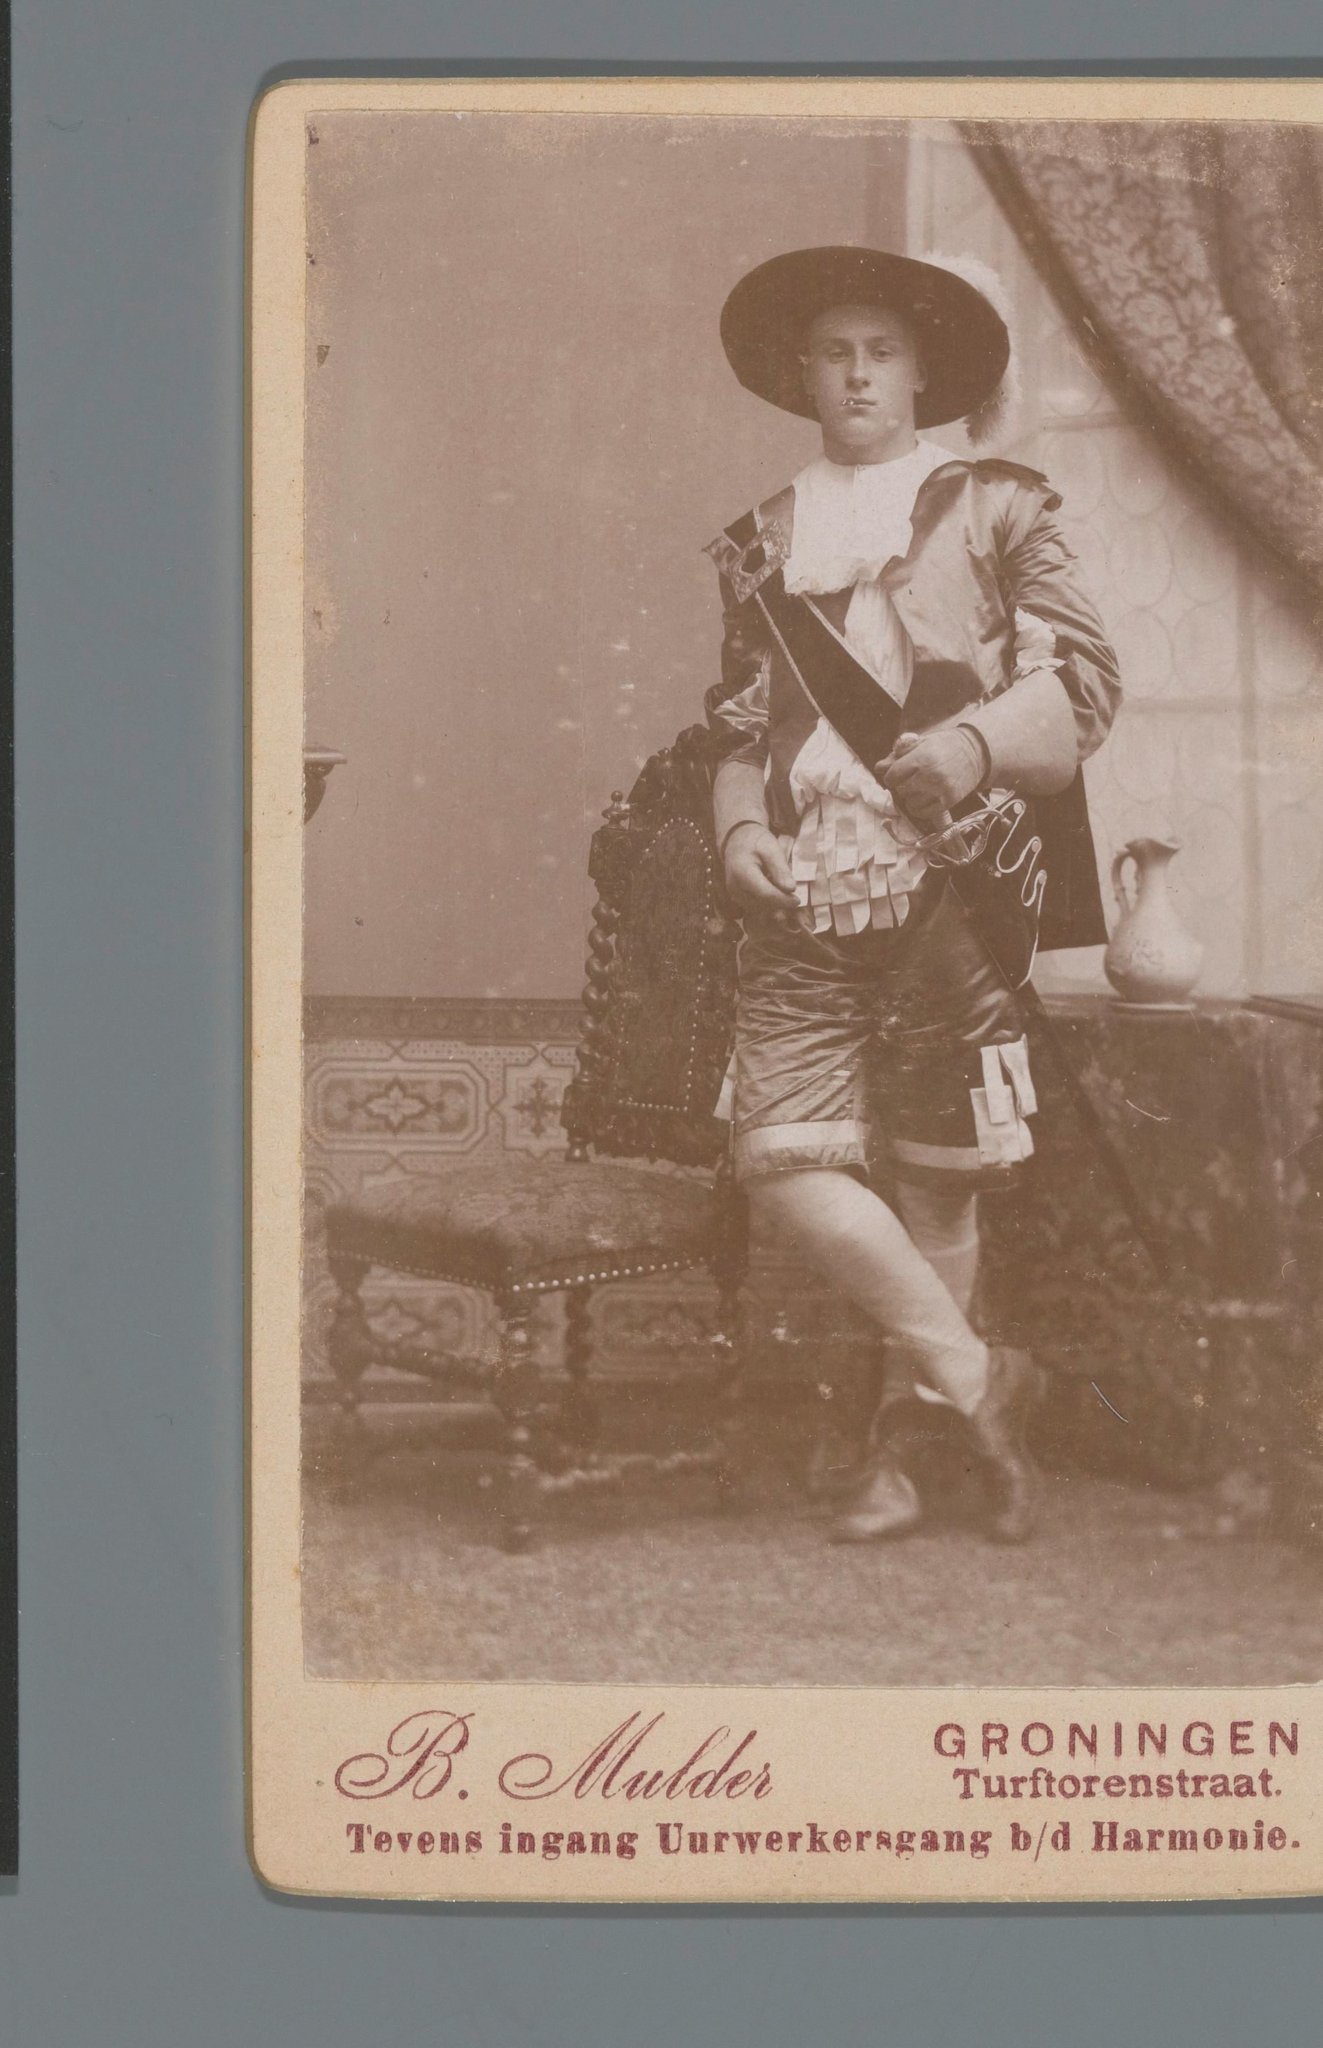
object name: carte de visite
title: Portret van een onbekende Groningse student in maskeradekostuum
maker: berend mulder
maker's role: fotograaf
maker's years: 1854-1926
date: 1886-1897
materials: paper, cardboard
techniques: collodion silver print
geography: groningen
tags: students' pageant, costumes used in pageants, anonymous historical person portrayed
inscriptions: inscription: ‘B. Mulder/ Groningen/ Turftorenstraat./ Tevens ingang Uurwerksgang b/d Harmonie’